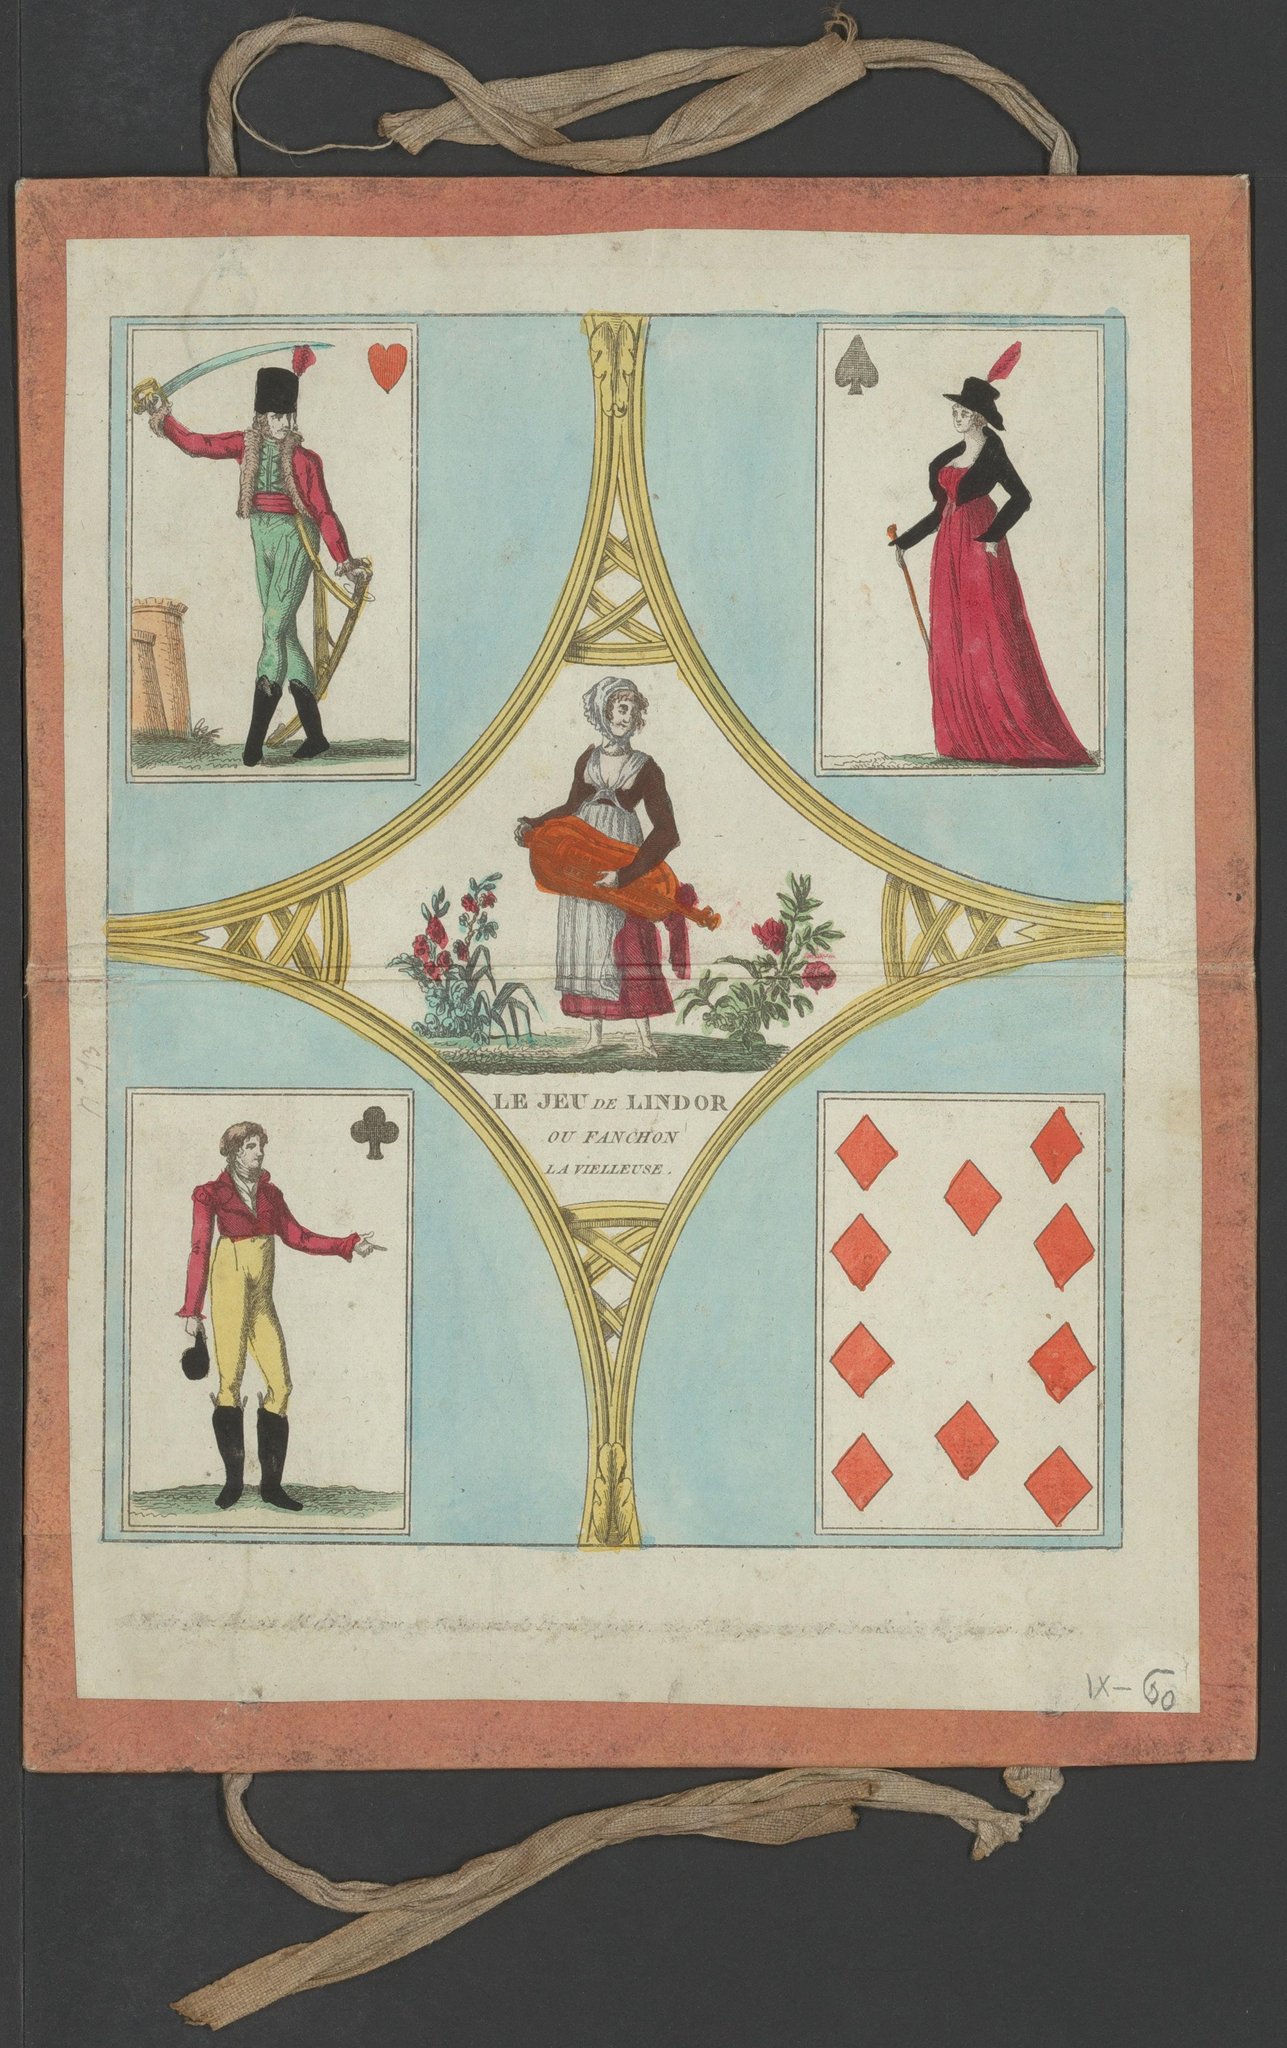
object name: print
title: Vier speelkaarten met een Parijse straatmuzikant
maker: Anonymous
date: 1800-1849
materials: cardboard, paper, ribbon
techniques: hand coloring, lithograph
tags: one person playing string instrument (plucked), popular music, street music, playing-cards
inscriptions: stamp, collector's mark: Lugt 1641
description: Een rechthoekig veld waar in de vier hoeken een speelkaart is afgebeeld. In het midden een afbeelding van een jonge vrouw met een hoofddoek en een draailier. Zij is Fanchon la Vielleuse een destijds bekende Parijse straatmuzikante. Op de verso de spelregels in het Frans. Onderwerpsrubrieken binnen de Atlas Zeden en Gewoonten: Zeden en gewoonten in engeren zin, Spel en vermaak, Gezelschapsspel II, Ganzenbord en dergelijke.